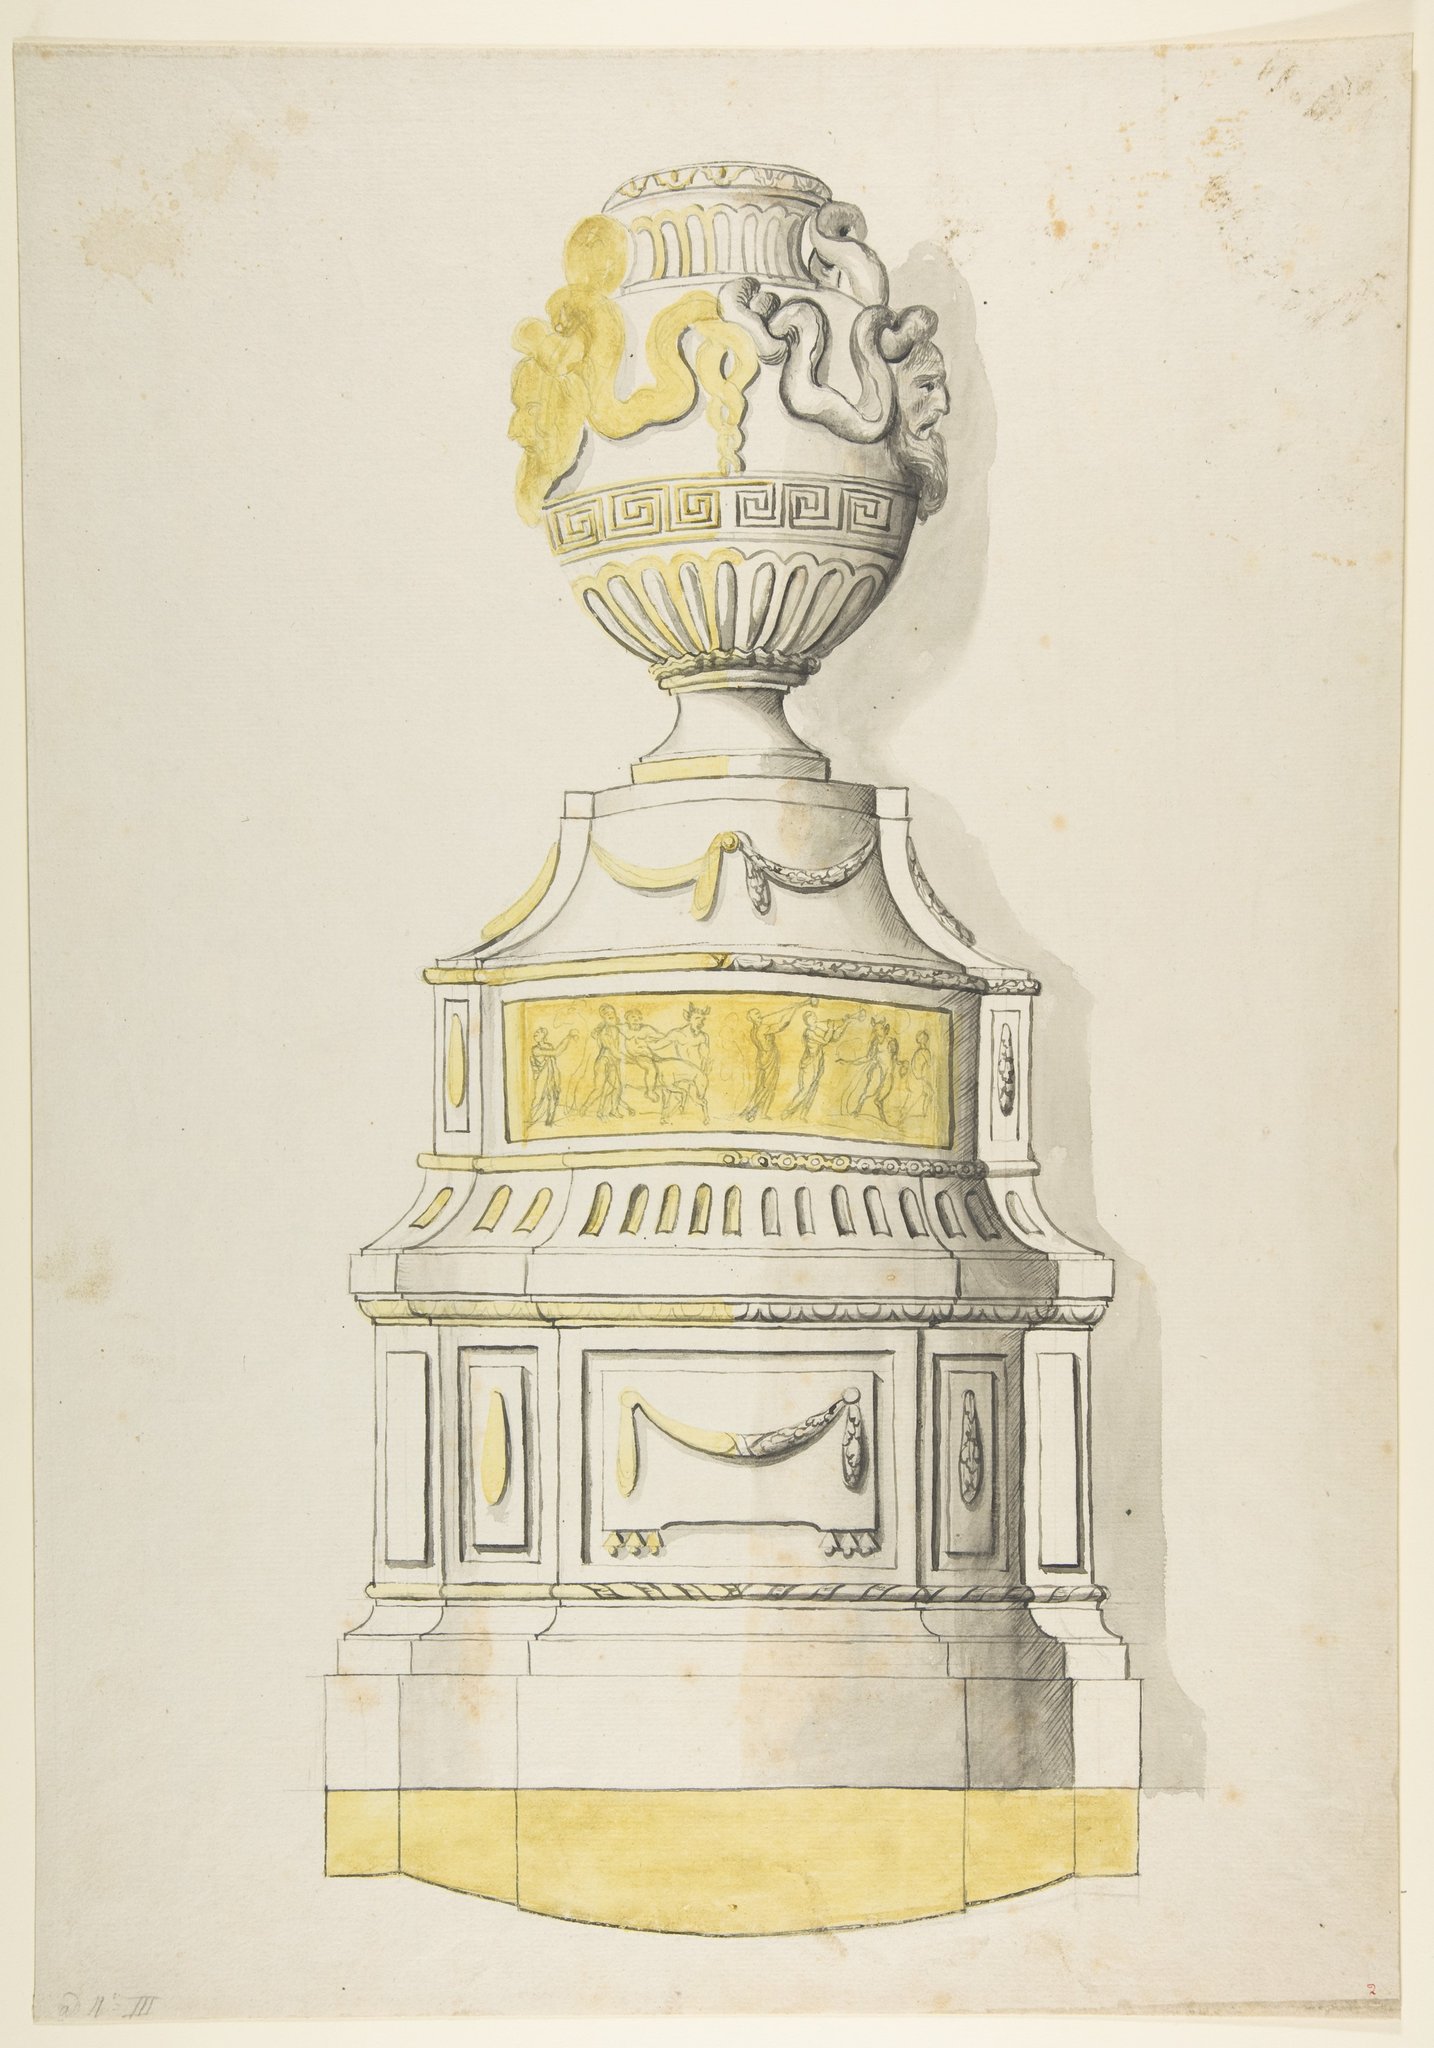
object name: drawing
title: Design for an Urn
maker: anonymous, french, 18th century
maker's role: artist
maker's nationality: french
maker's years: 1700-1800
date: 1770-1790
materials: graphite, ink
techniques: brush, pen, wash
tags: men,satyrs,horses,urns